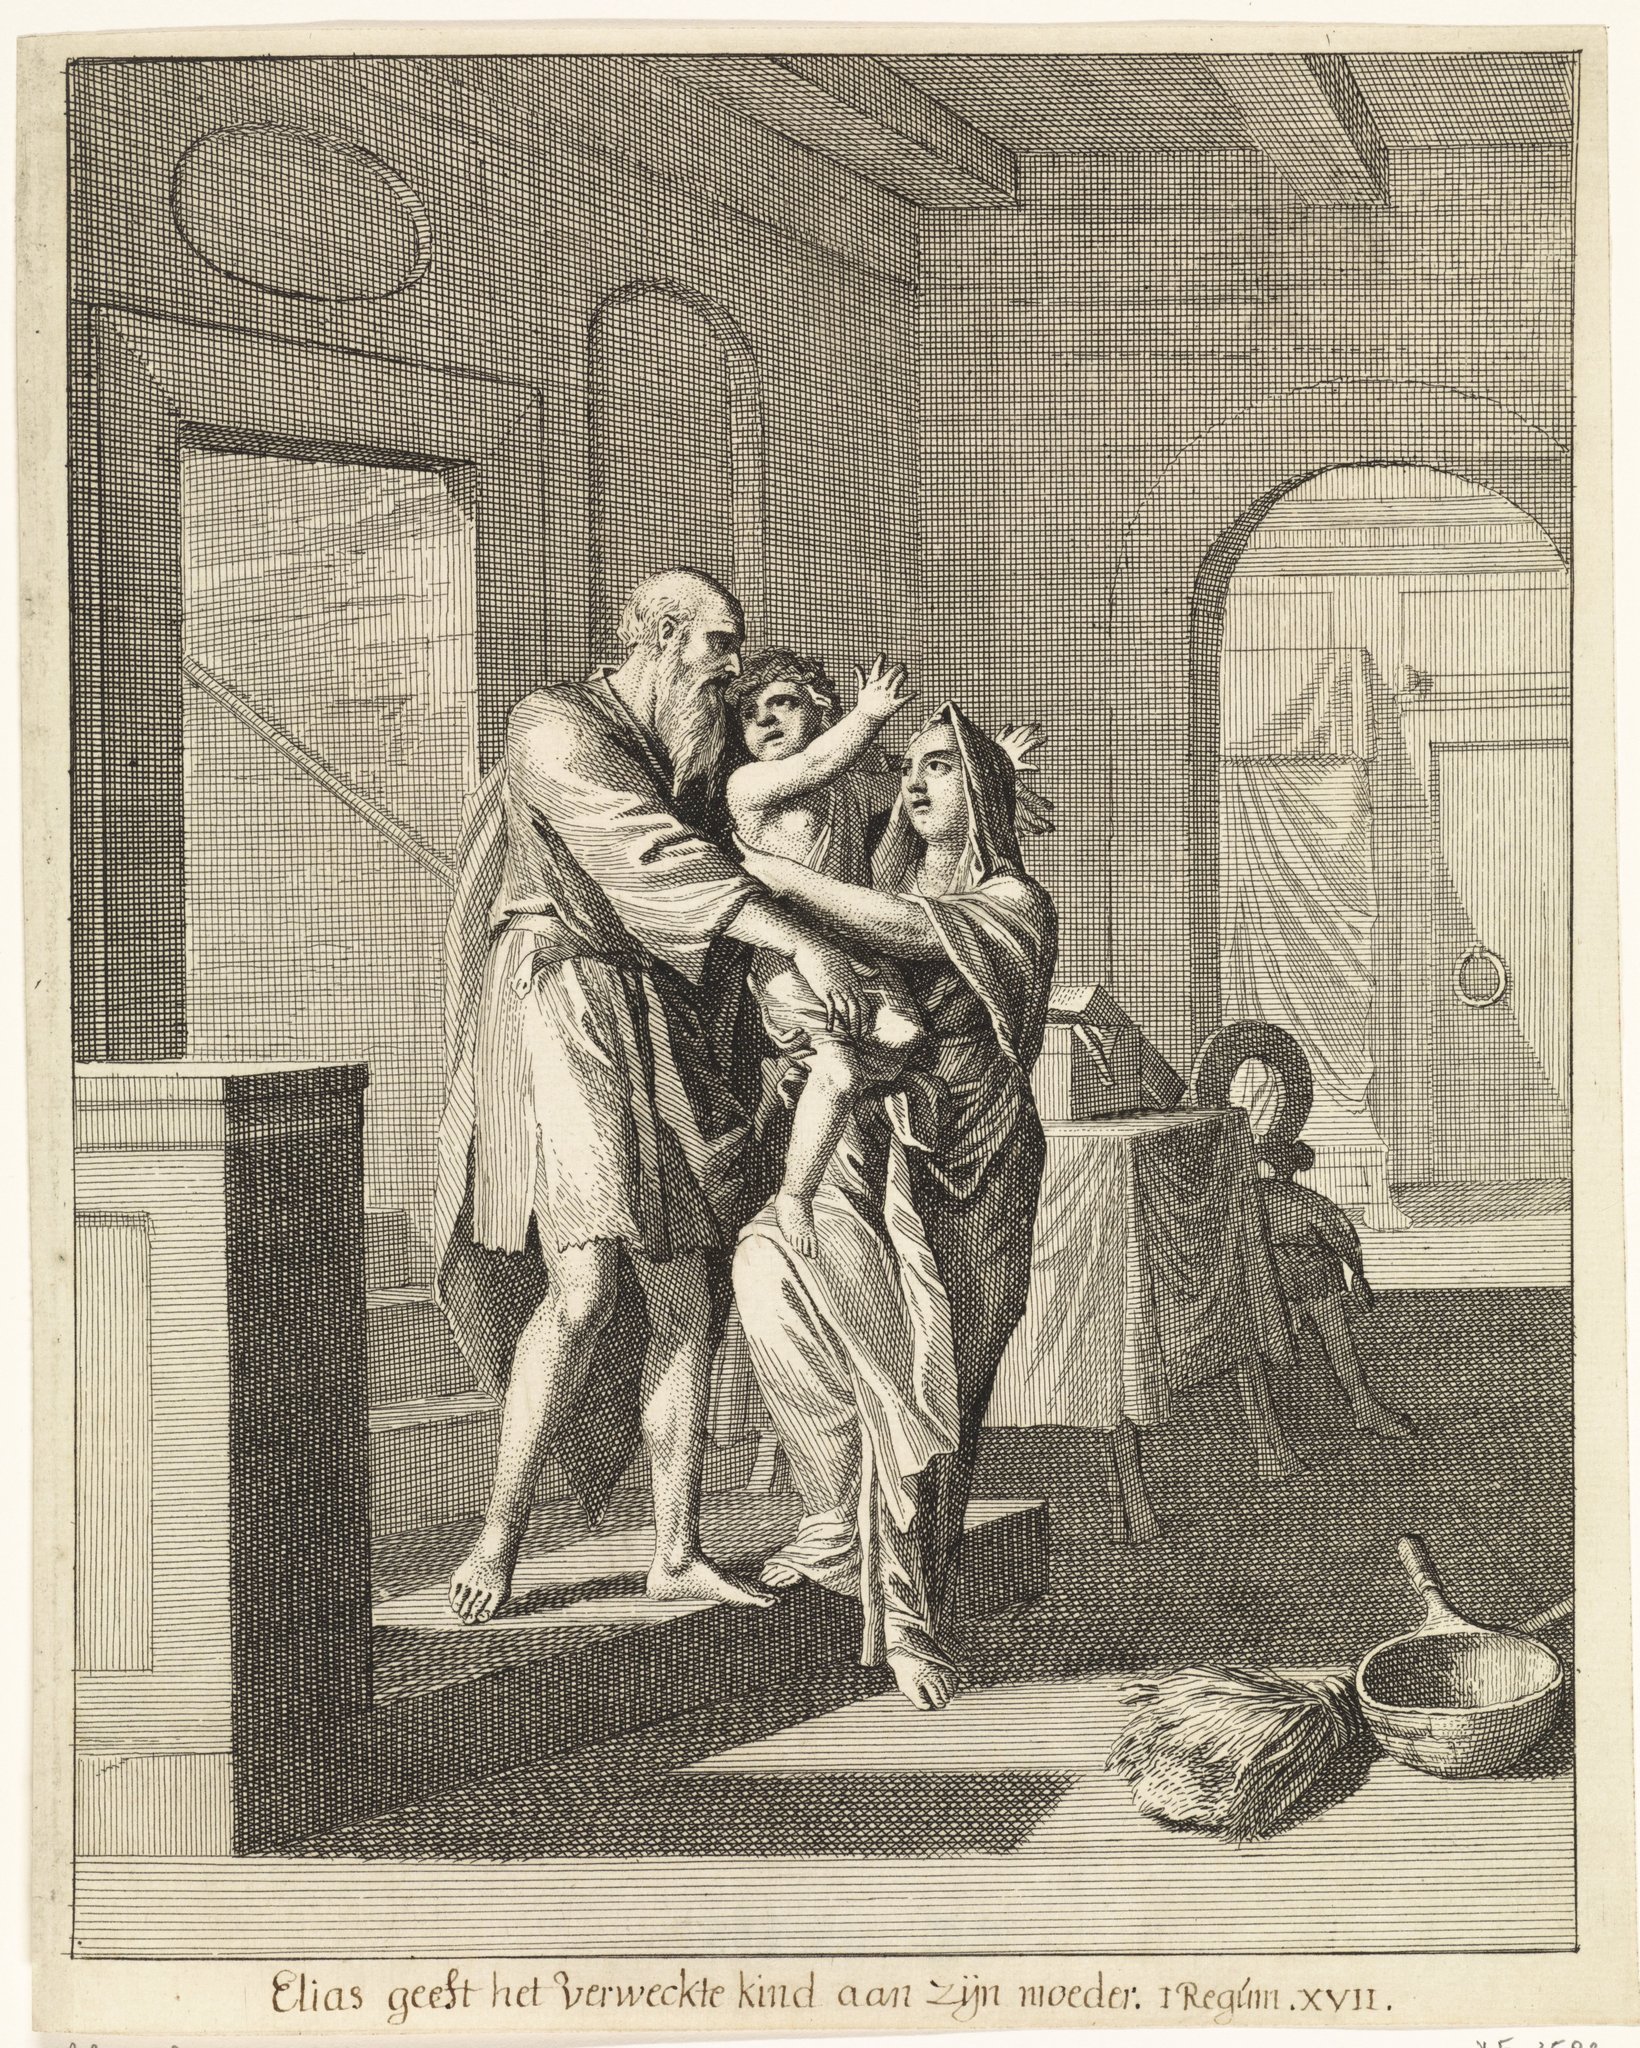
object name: print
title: Elisa wekt de zoon van de vrouw uit Sunem op uit de dood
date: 1708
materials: paper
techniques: etching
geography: nuremberg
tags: elijah takes the child of the widow of zarephath and carries him upstairs (+ variant)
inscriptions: collector's mark: Lugt 2228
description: Proefdruk van een prent welke is opgenomen als illustratie in: Historiae Celebriores Veteris Testamenti. Christoph Weigel, 1708.